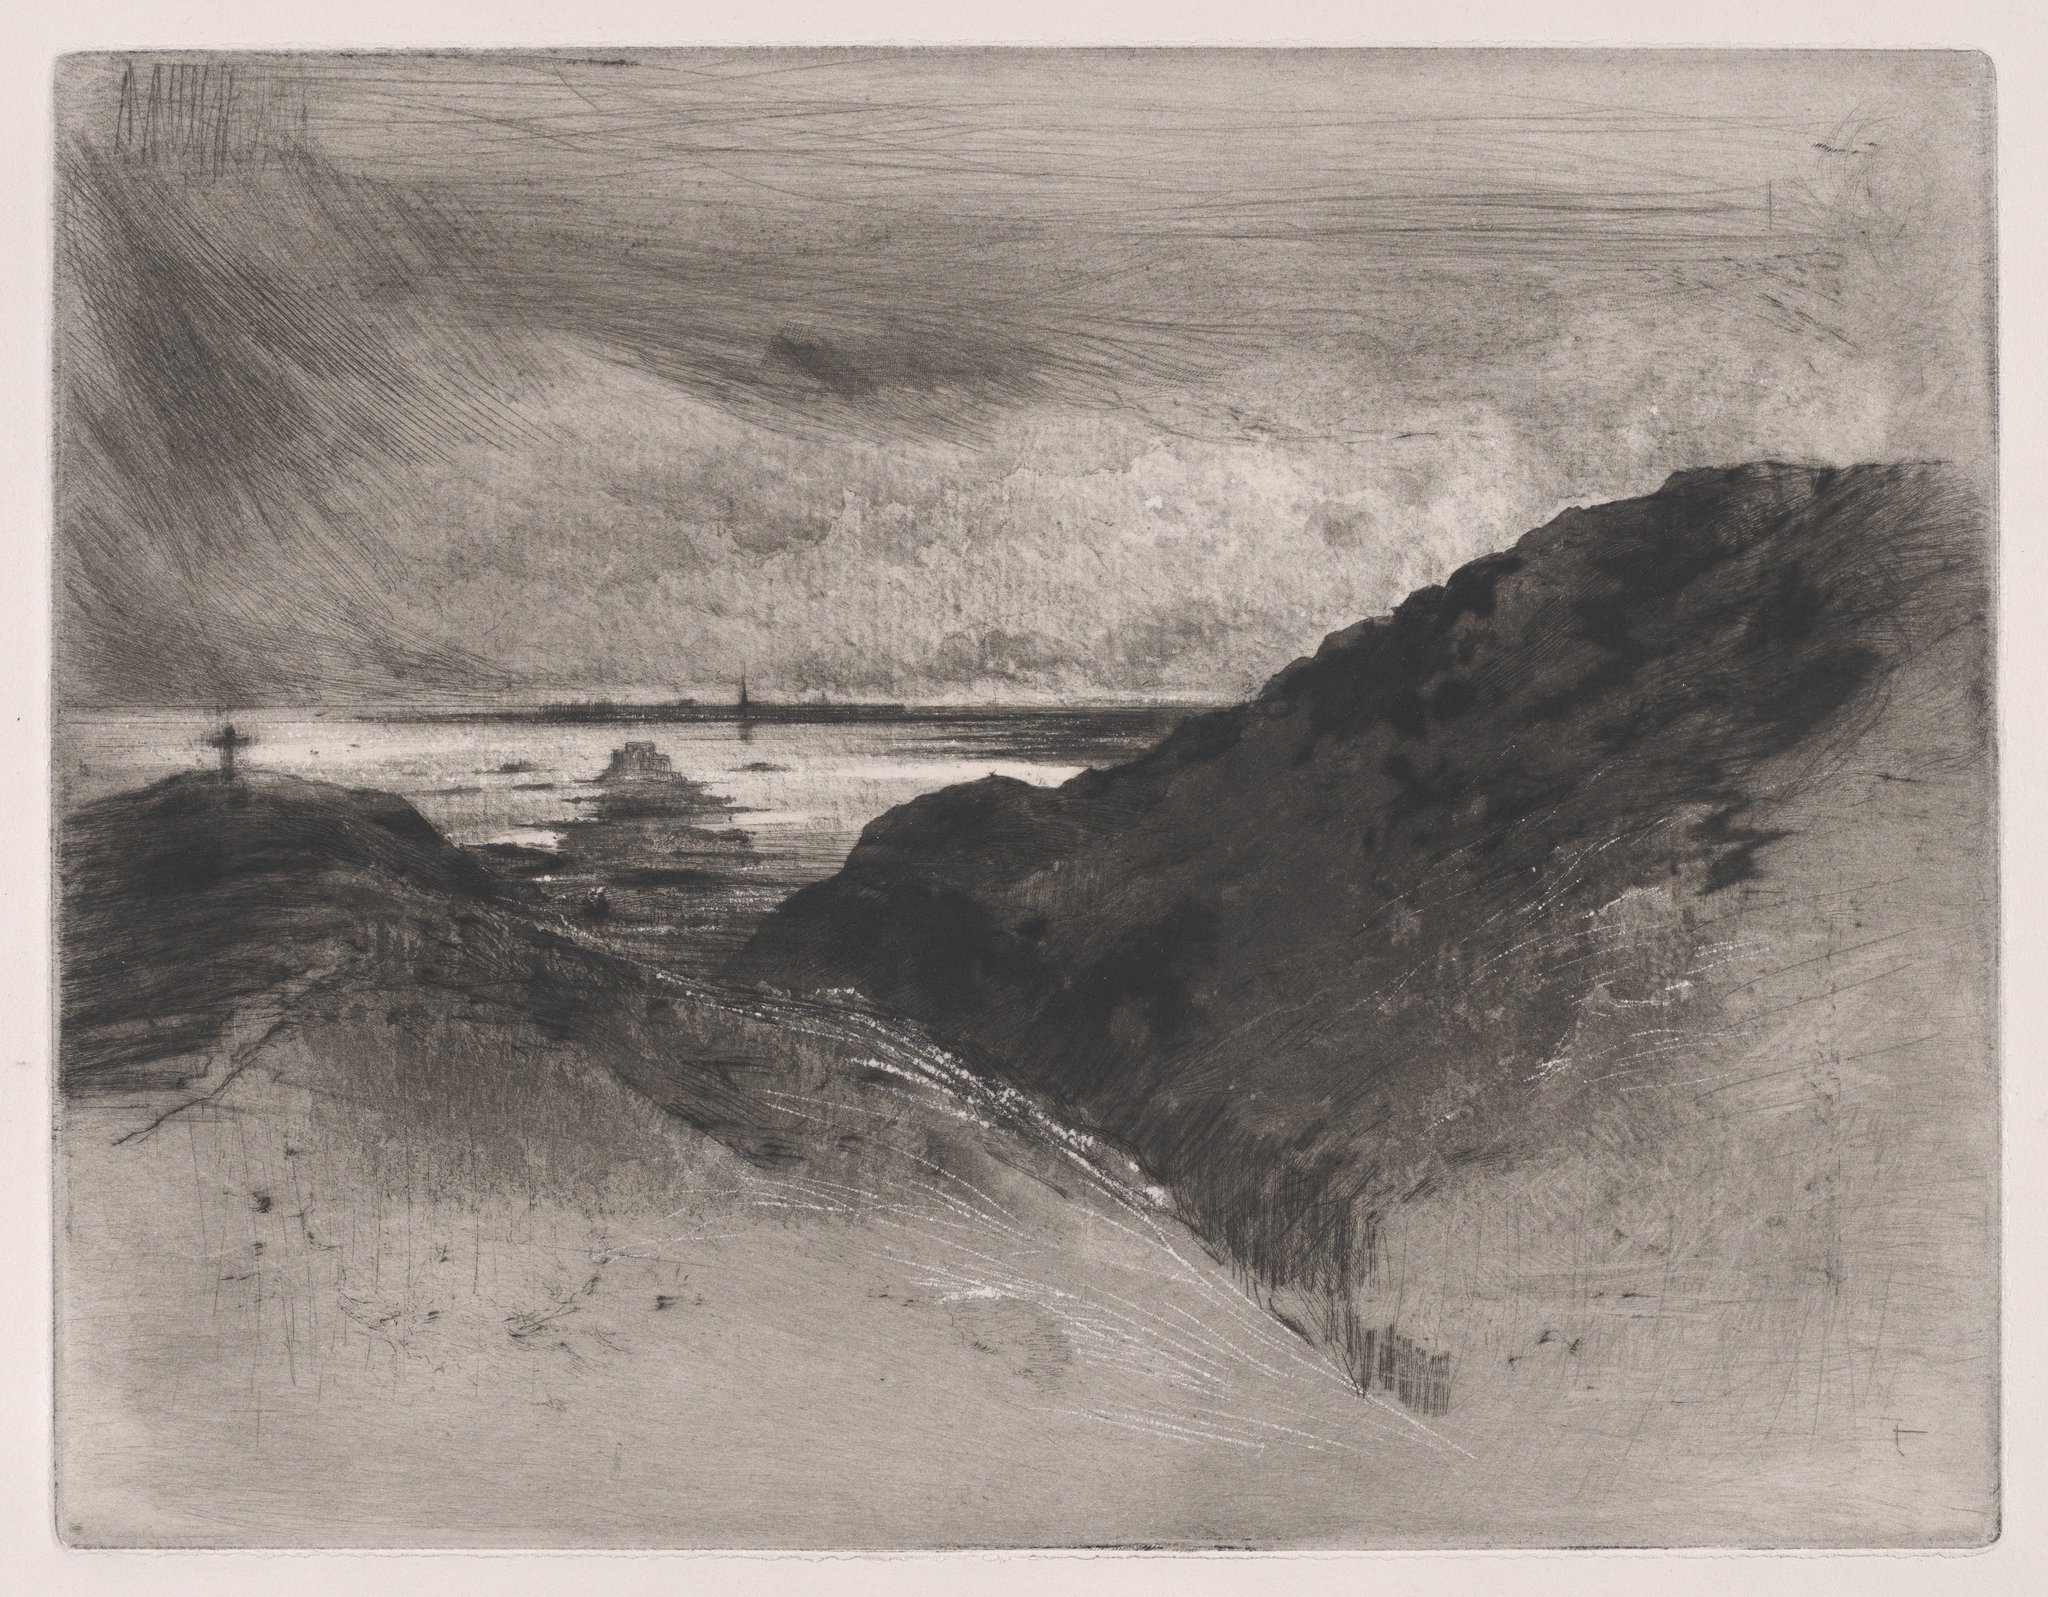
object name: print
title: The Cliff - Bay of Saint-Malo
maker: félix-hilaire buhot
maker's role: artist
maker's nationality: french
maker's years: 1847-1898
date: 1889-1890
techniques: aquatint, drypoint, etching, highlighting, roulette, scraping